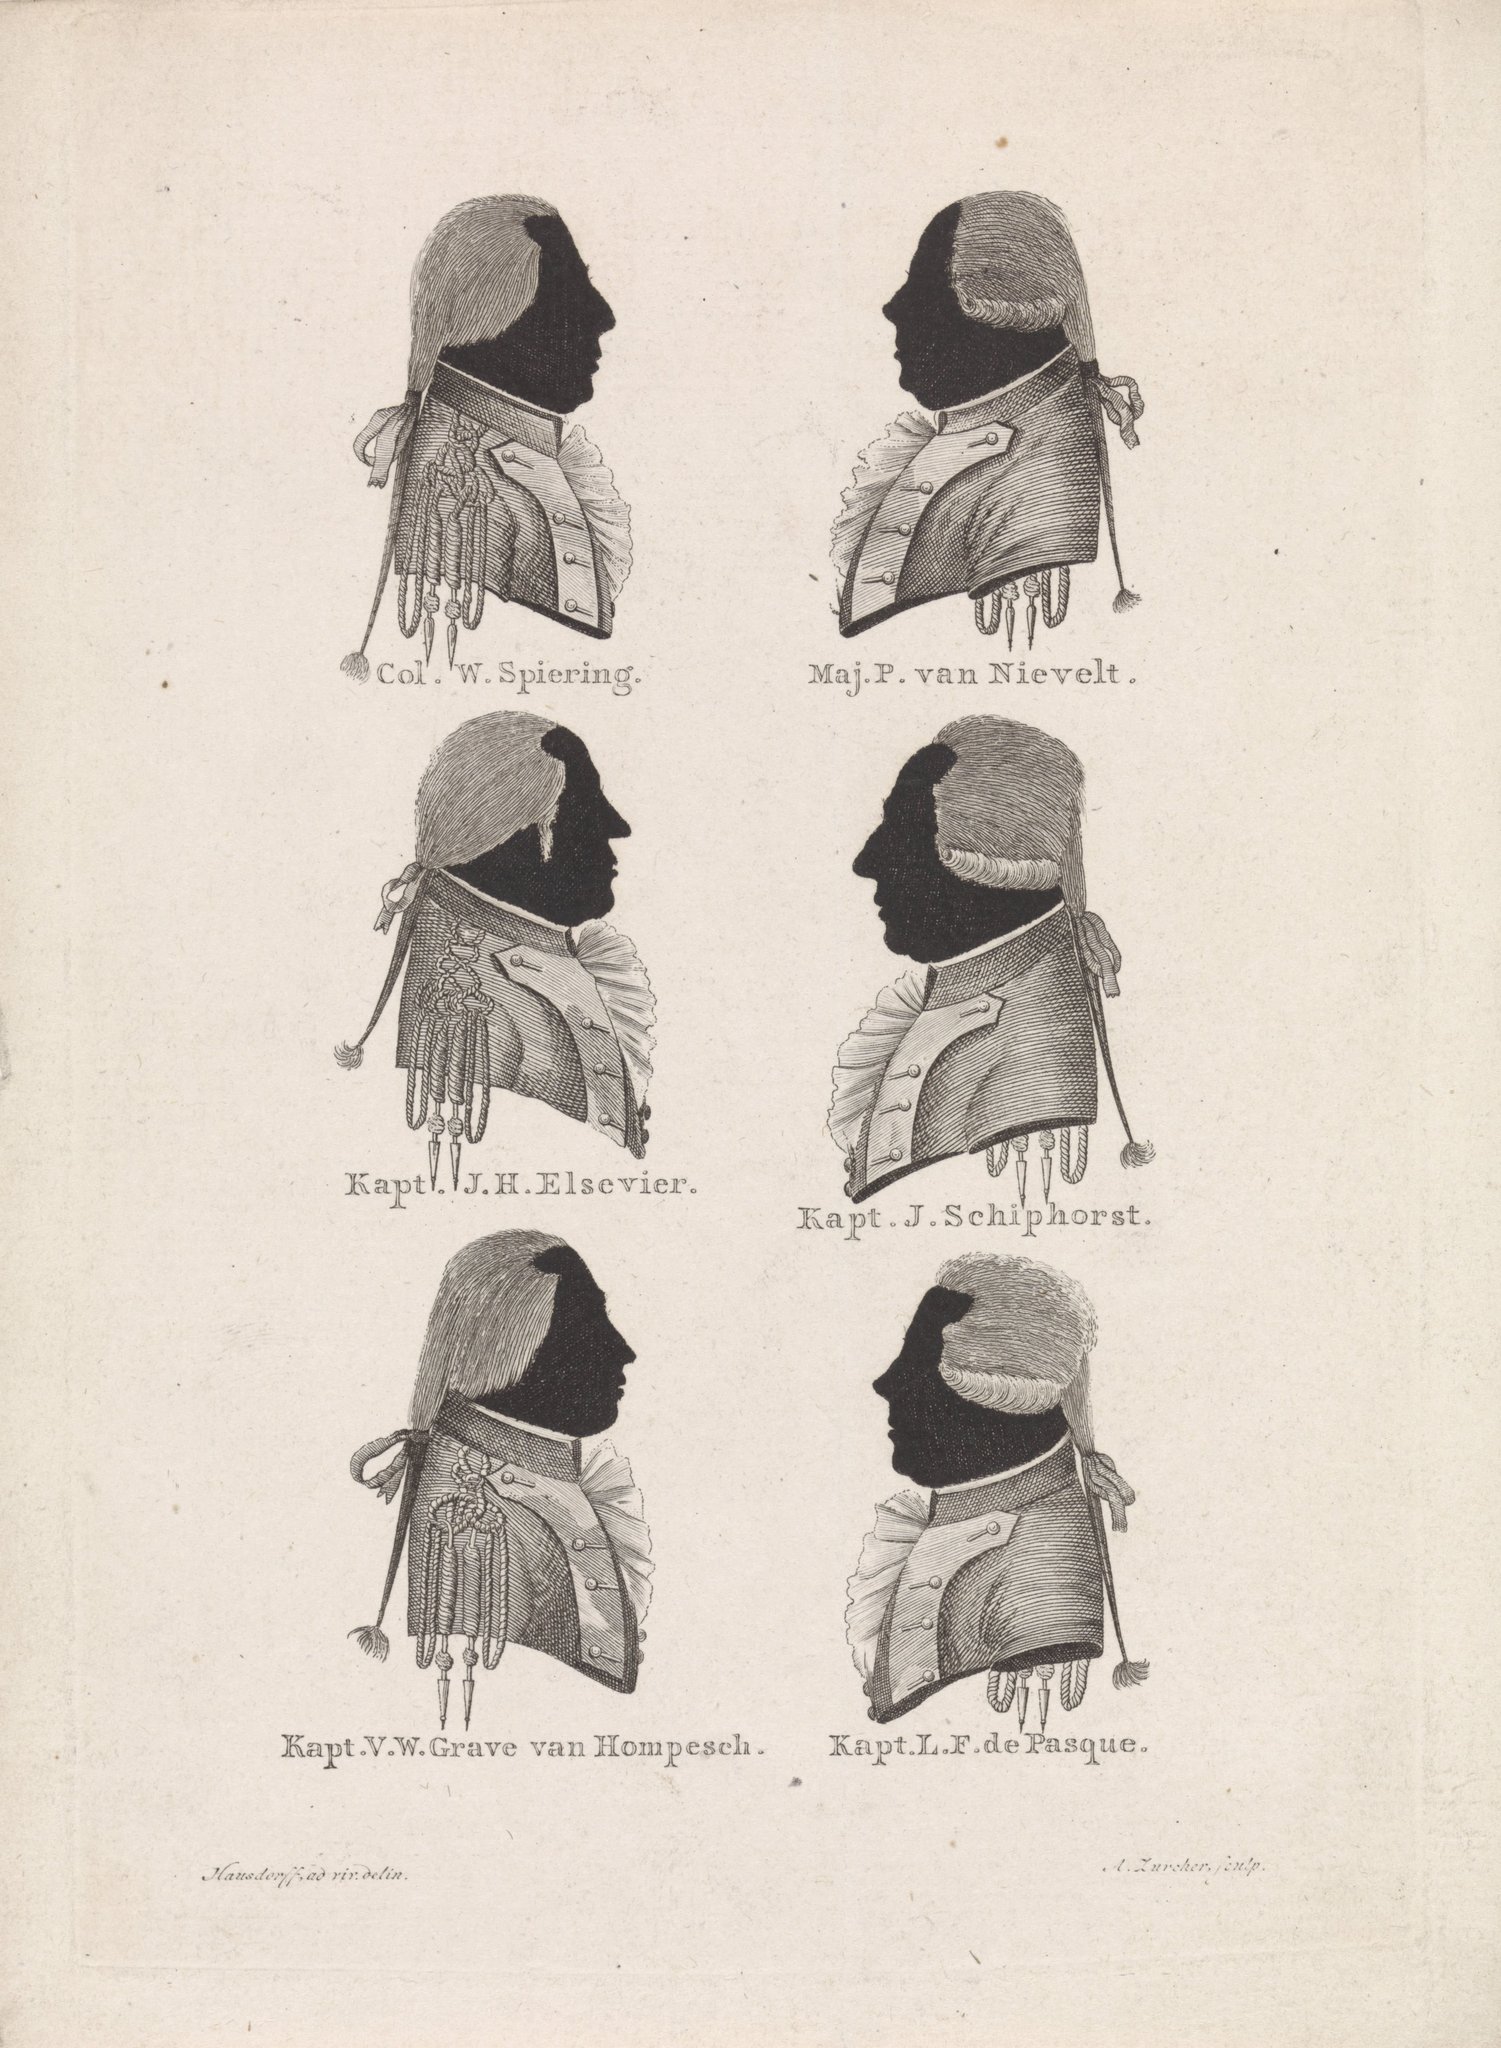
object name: print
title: Silhouetportretten van W. Spiering, P. van Nievelt, J.H. Elsevier, J. Schiphorst, V.W. van Hompesch en L.F. de Pasque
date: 1793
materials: paper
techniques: engraving, etching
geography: amsterdam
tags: kapitein, l.f. de pasque, v.w. van hompesch, j. schiphorst, j.h. elsevier, majoor, p. van nievelt, kolonel, w. spiering, beleg van willemstad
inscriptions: collector's mark: Lugt 2228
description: Prent uit: Oldenborgh, Pieter van. De belegering en verdediging van de Willemstad, in maart MDCCXCIII. Amsterdam: Johannes Allart, Dordrecht: Abraham en Pieter Blussé, 1793.